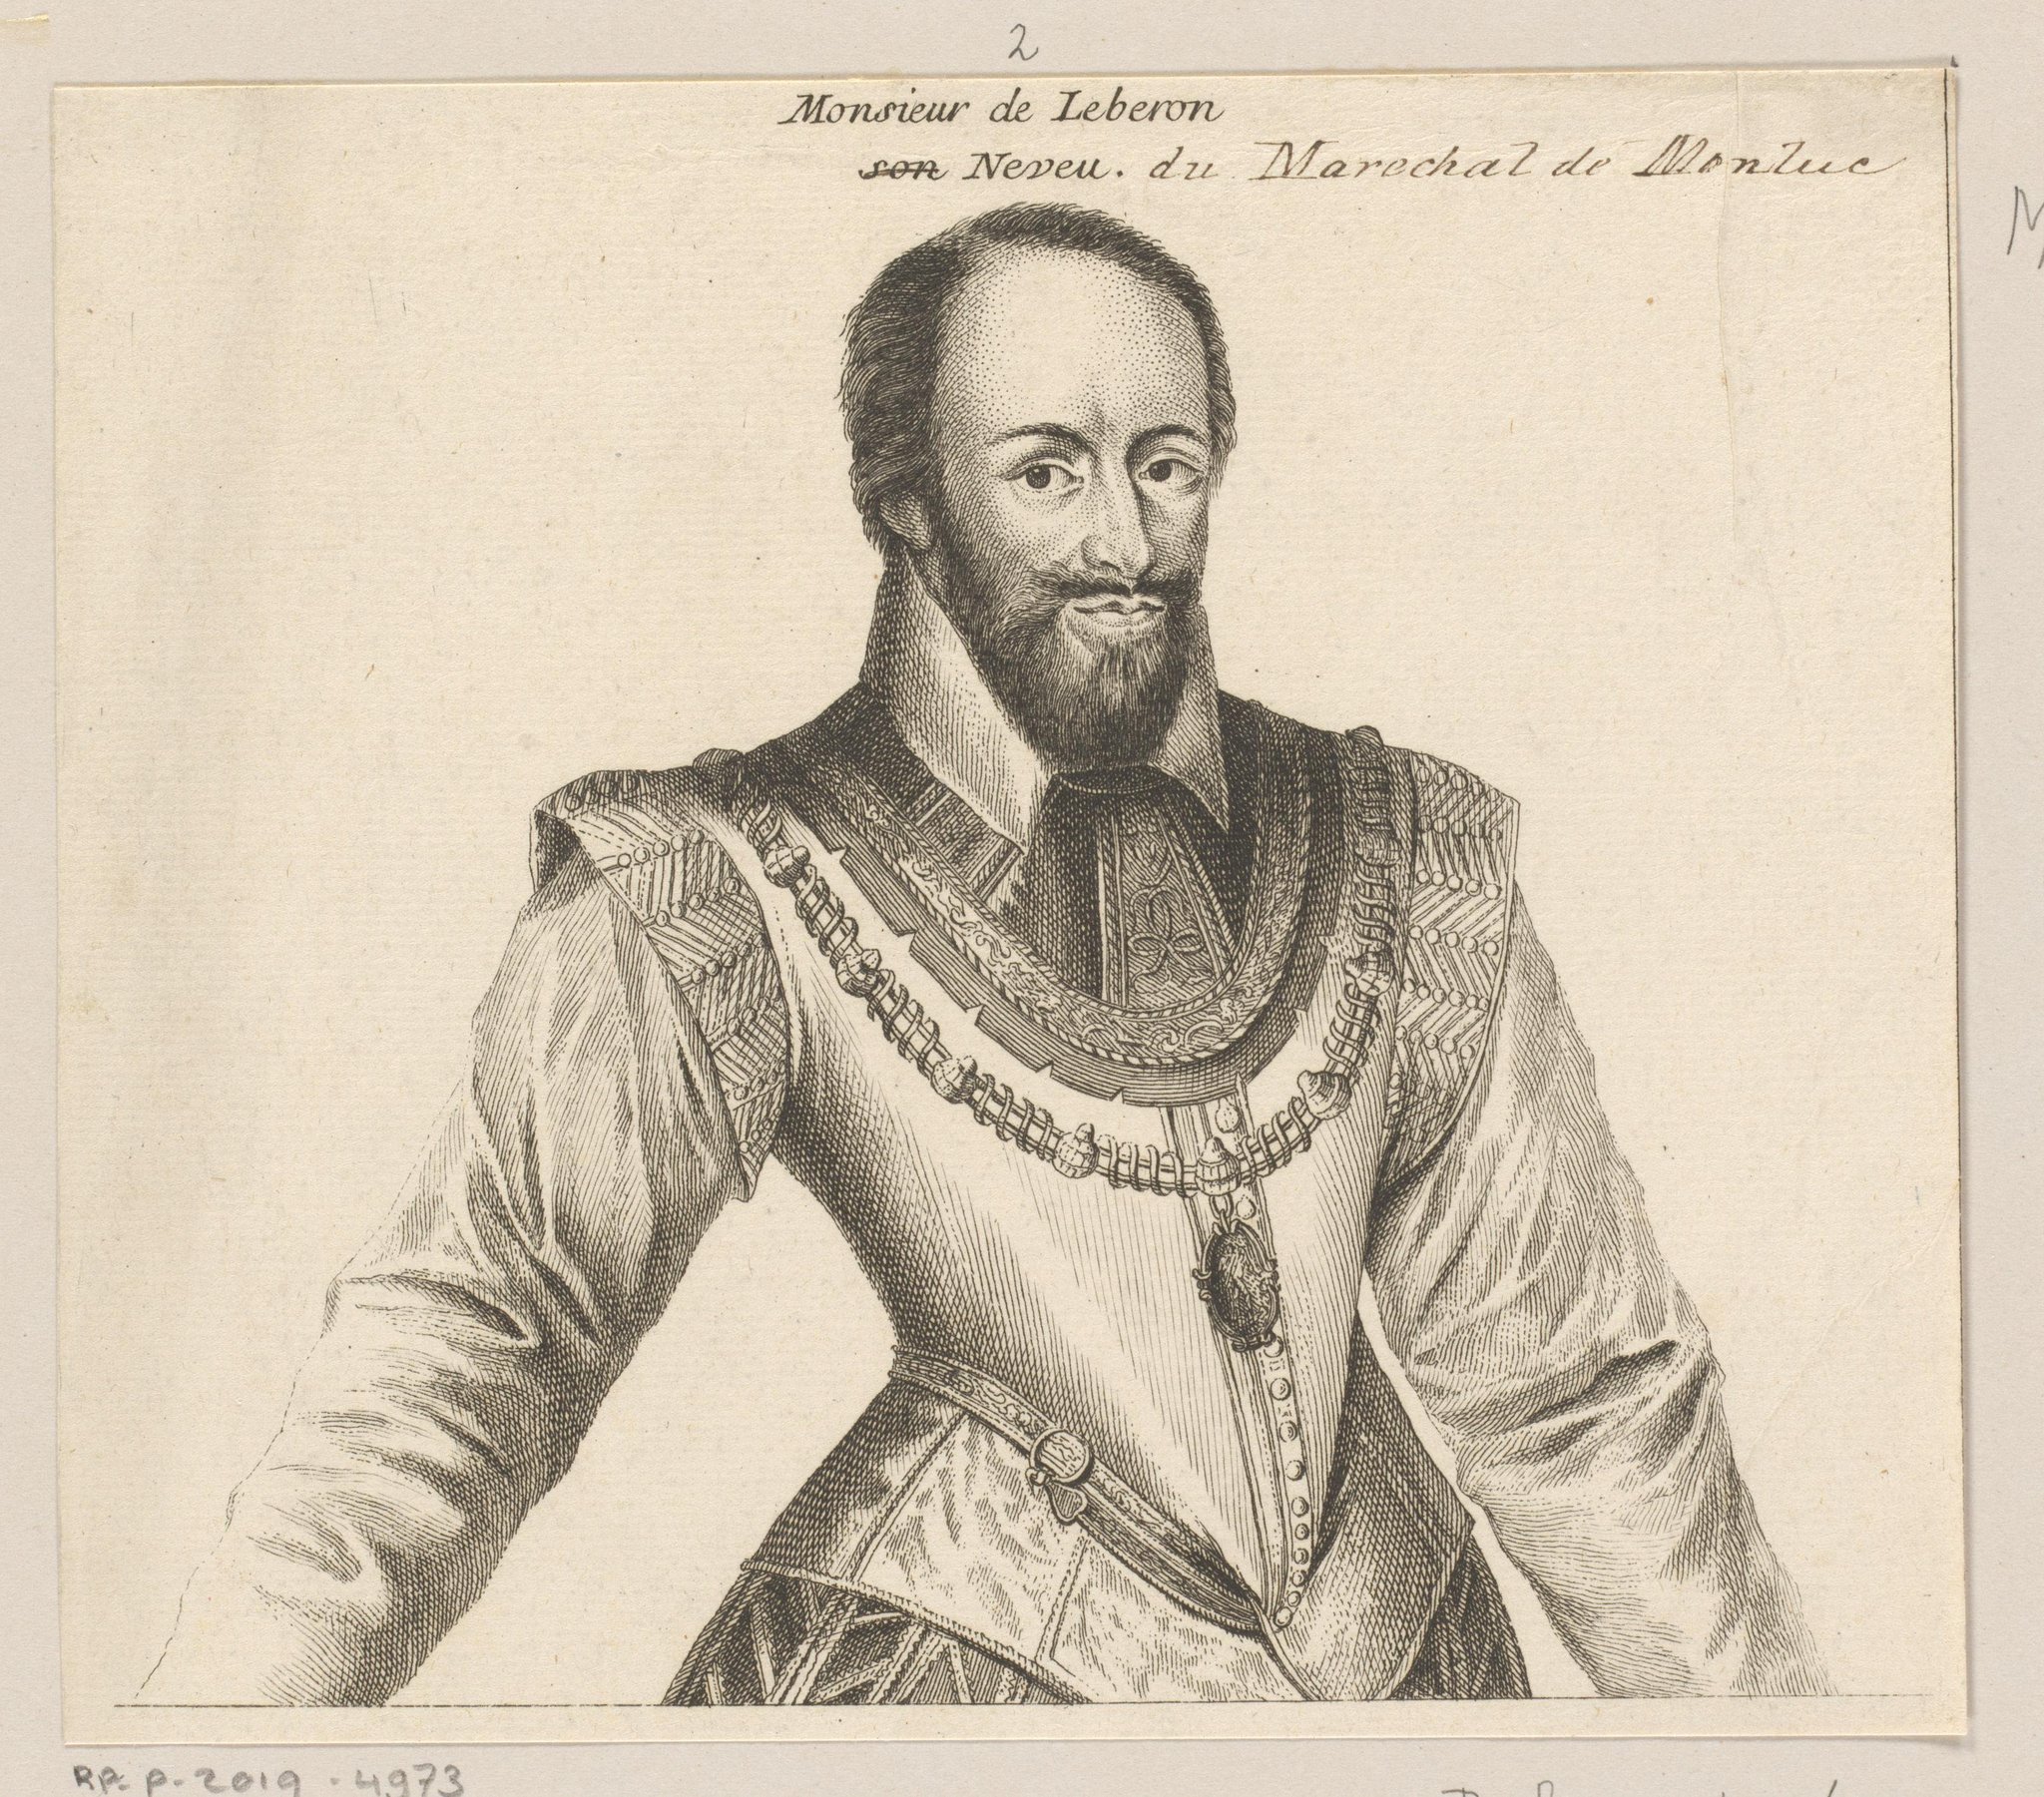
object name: print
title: Portret van Antoine Gélas de Léberon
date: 1729-1733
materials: paper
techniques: etching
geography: paris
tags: historical persons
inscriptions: inscription: ‘du marechal de monluc’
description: Prent uit: Montfaucon, Bernard de. Les monumens de la Monarchie Françoise (...). Parijs: Julien-Michel Gandouin en Pierre-François Giffart, 1729-1733.